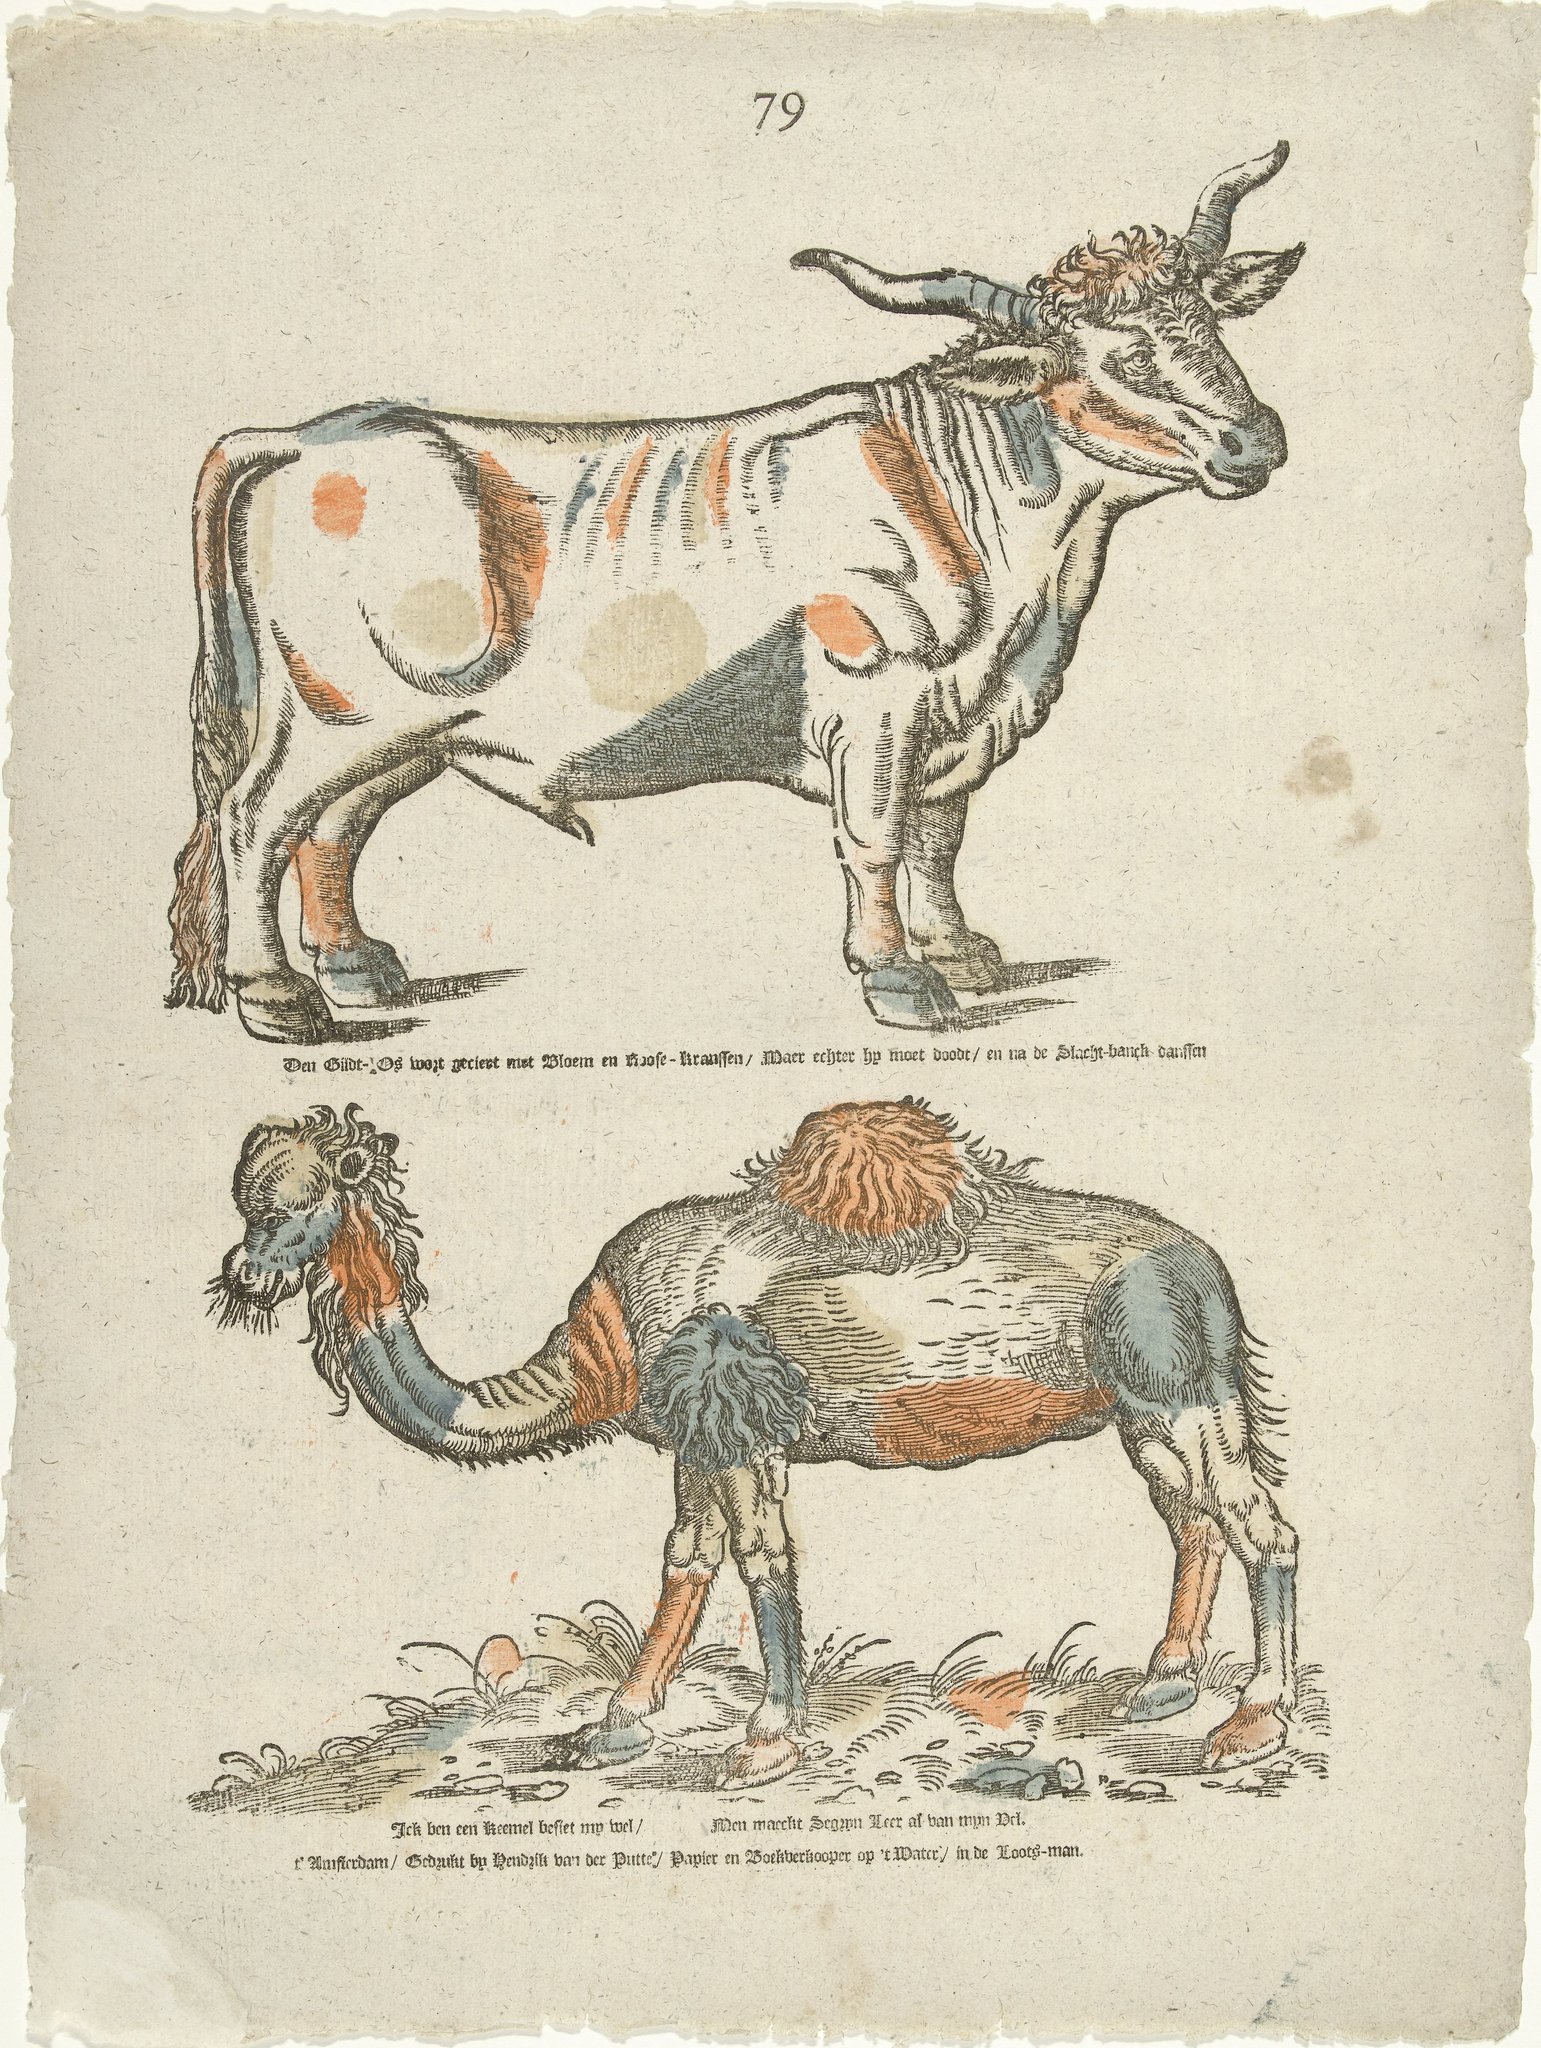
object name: popular print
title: Den Gildt-Os wort geciert met Bloem en Roose-kranssen (...) / Ick ben een Keemel besiet my wel (...)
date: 1551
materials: paper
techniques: colour, letterpress printing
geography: amsterdam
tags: hoofed animals: camel, hoofed animals: dromedary, prize-ox, ox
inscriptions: inscription: ‘Gildeos’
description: Voor het drukken van deze prent is gebruik gemaakt van bestaande houtblokken die in de zestiende eeuw gebruikt werden voor de befaamde natuurhistorische boeken van de Zwitser Conrad Gessner. Minstens een deel van de houtblokken voor de illustraties van Gessners werk bevond zich in de achttiende en vroege negentiende eeuw in Nederland. Daar werden ze benut voor het drukken van cents- of volksprenten. De nogal willekeurige kleuring op de prenten is typerend voor dit soort goedkope grafiek. Opvallend is dat de dieren in de tekstjes die onder de afbeeldingen werden toegevoegd vaak anders zijn geduid dan bij Gessner. Deze dieren komen voor in verschillende publicaties van Gessner, alsmede herdrukken daarvan, zoals het eerste deel van Historiae animalium (eerste uitgave 1551), Icones animalium quadrupedum (eerste uitgave 1553) en Thierbuch (eerste uitgave 1563).